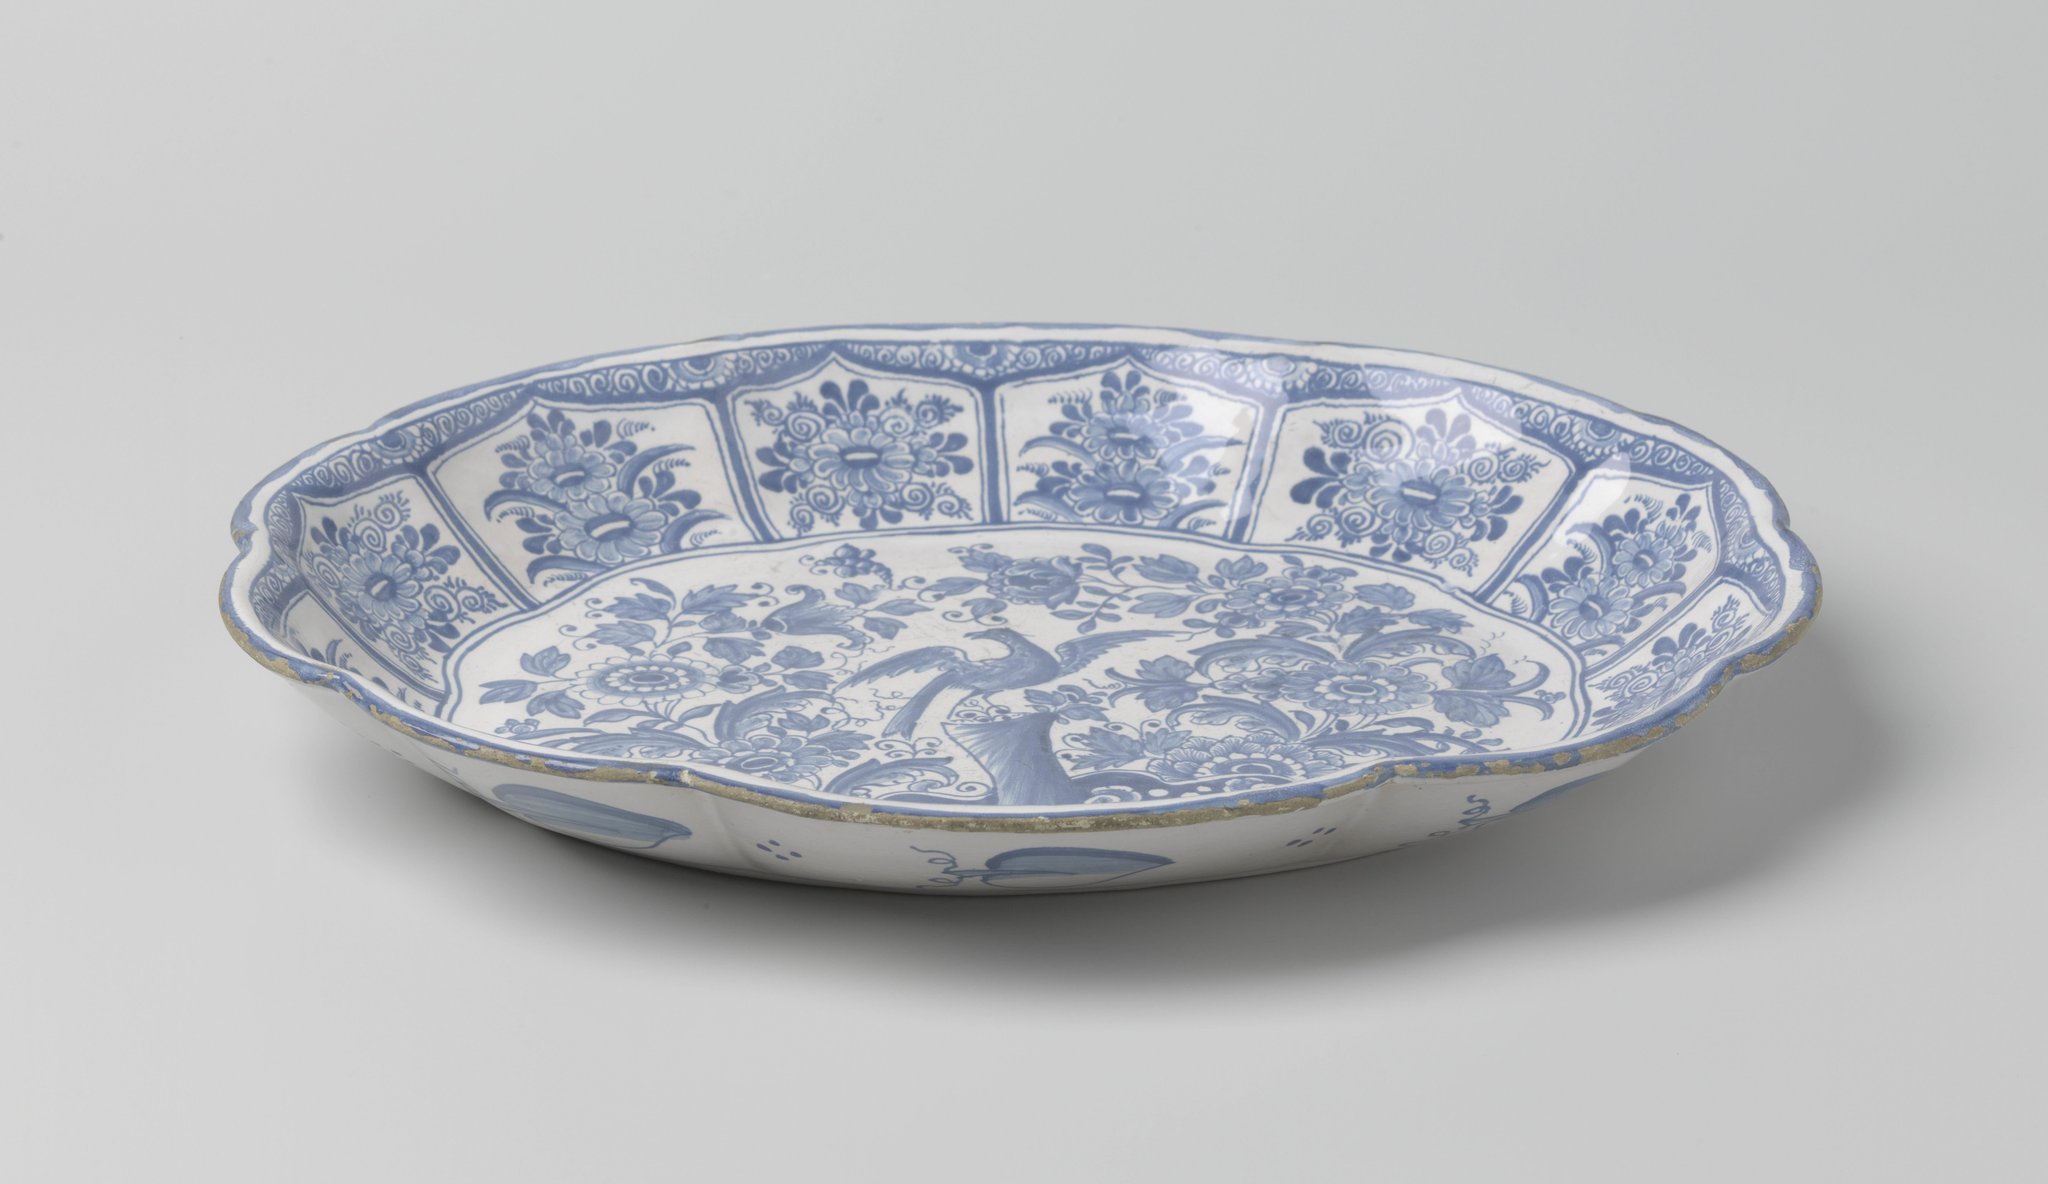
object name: dish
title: Schaal, beschilderd in blauw met een vogel omgeven door bloemtakken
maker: johann georg knöller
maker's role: plateelbakker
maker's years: 1678-1939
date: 1730-1740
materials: faience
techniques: painted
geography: bayreuth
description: Ewer and basin. Faience with grand feu decoration. Bayreuth (Germany), c. 1730 - 1740, factory of Johann Georg Knöller, decoration of basin by Johann Clarner.